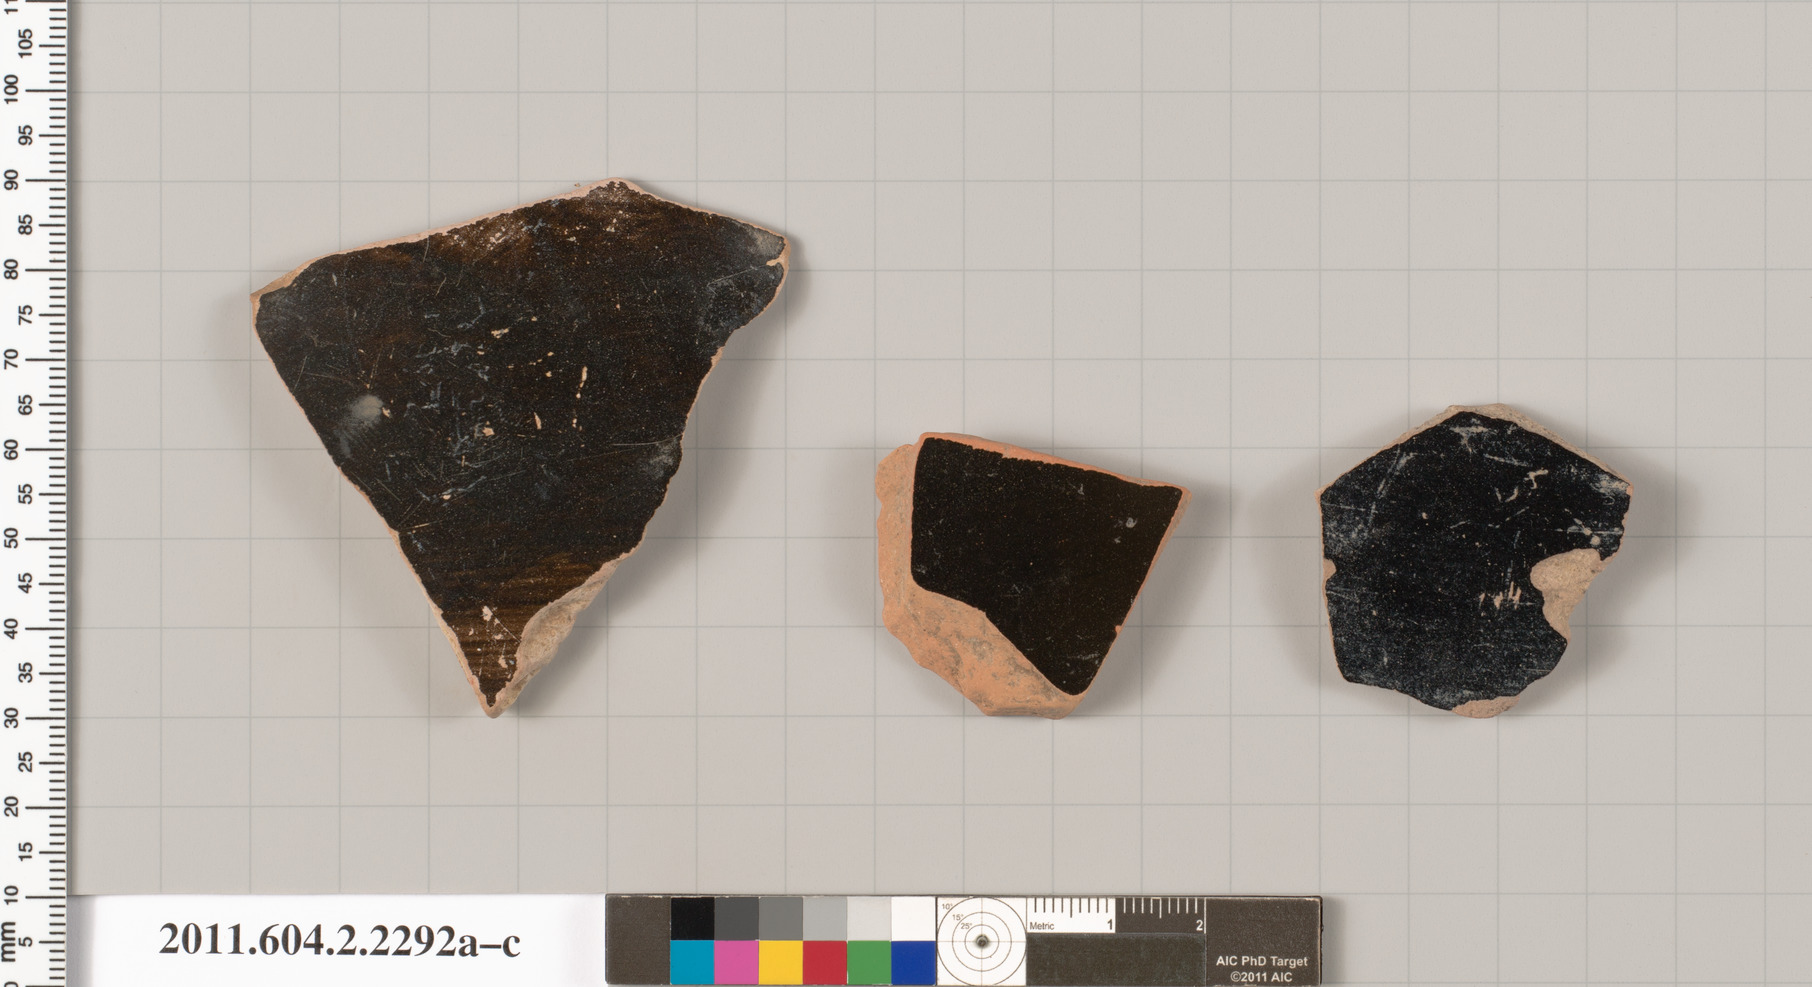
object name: column krater fragment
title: Terracotta fragments of column-kraters (bowls for mixing wine and water)?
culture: greek, attic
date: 475-451 BCE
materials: terracotta